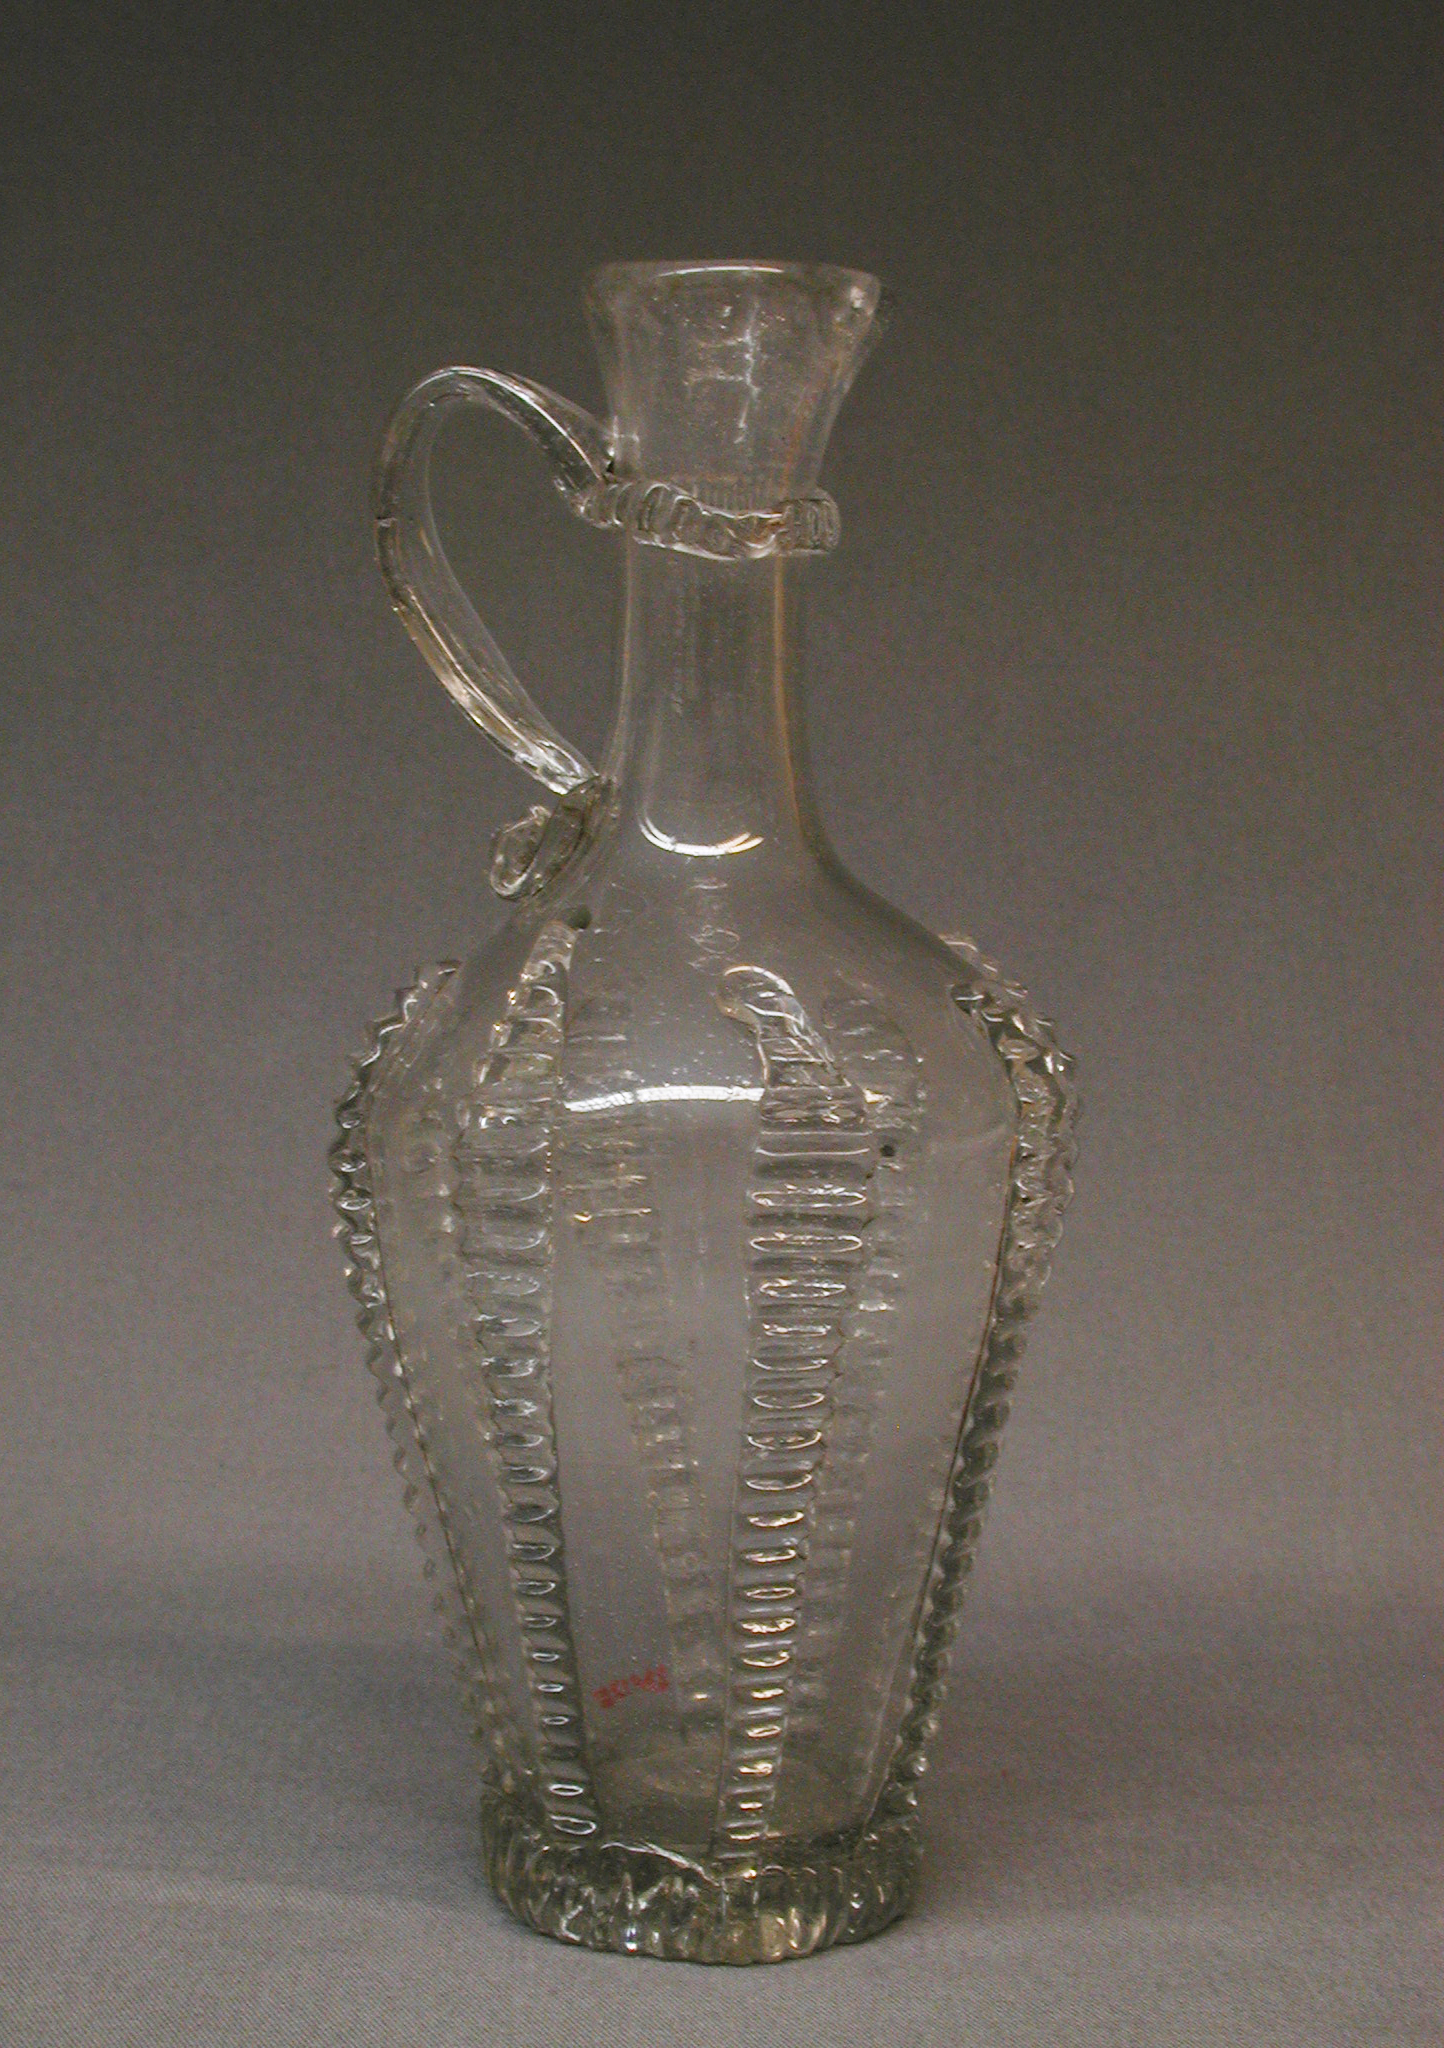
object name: jug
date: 1601-1800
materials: glass